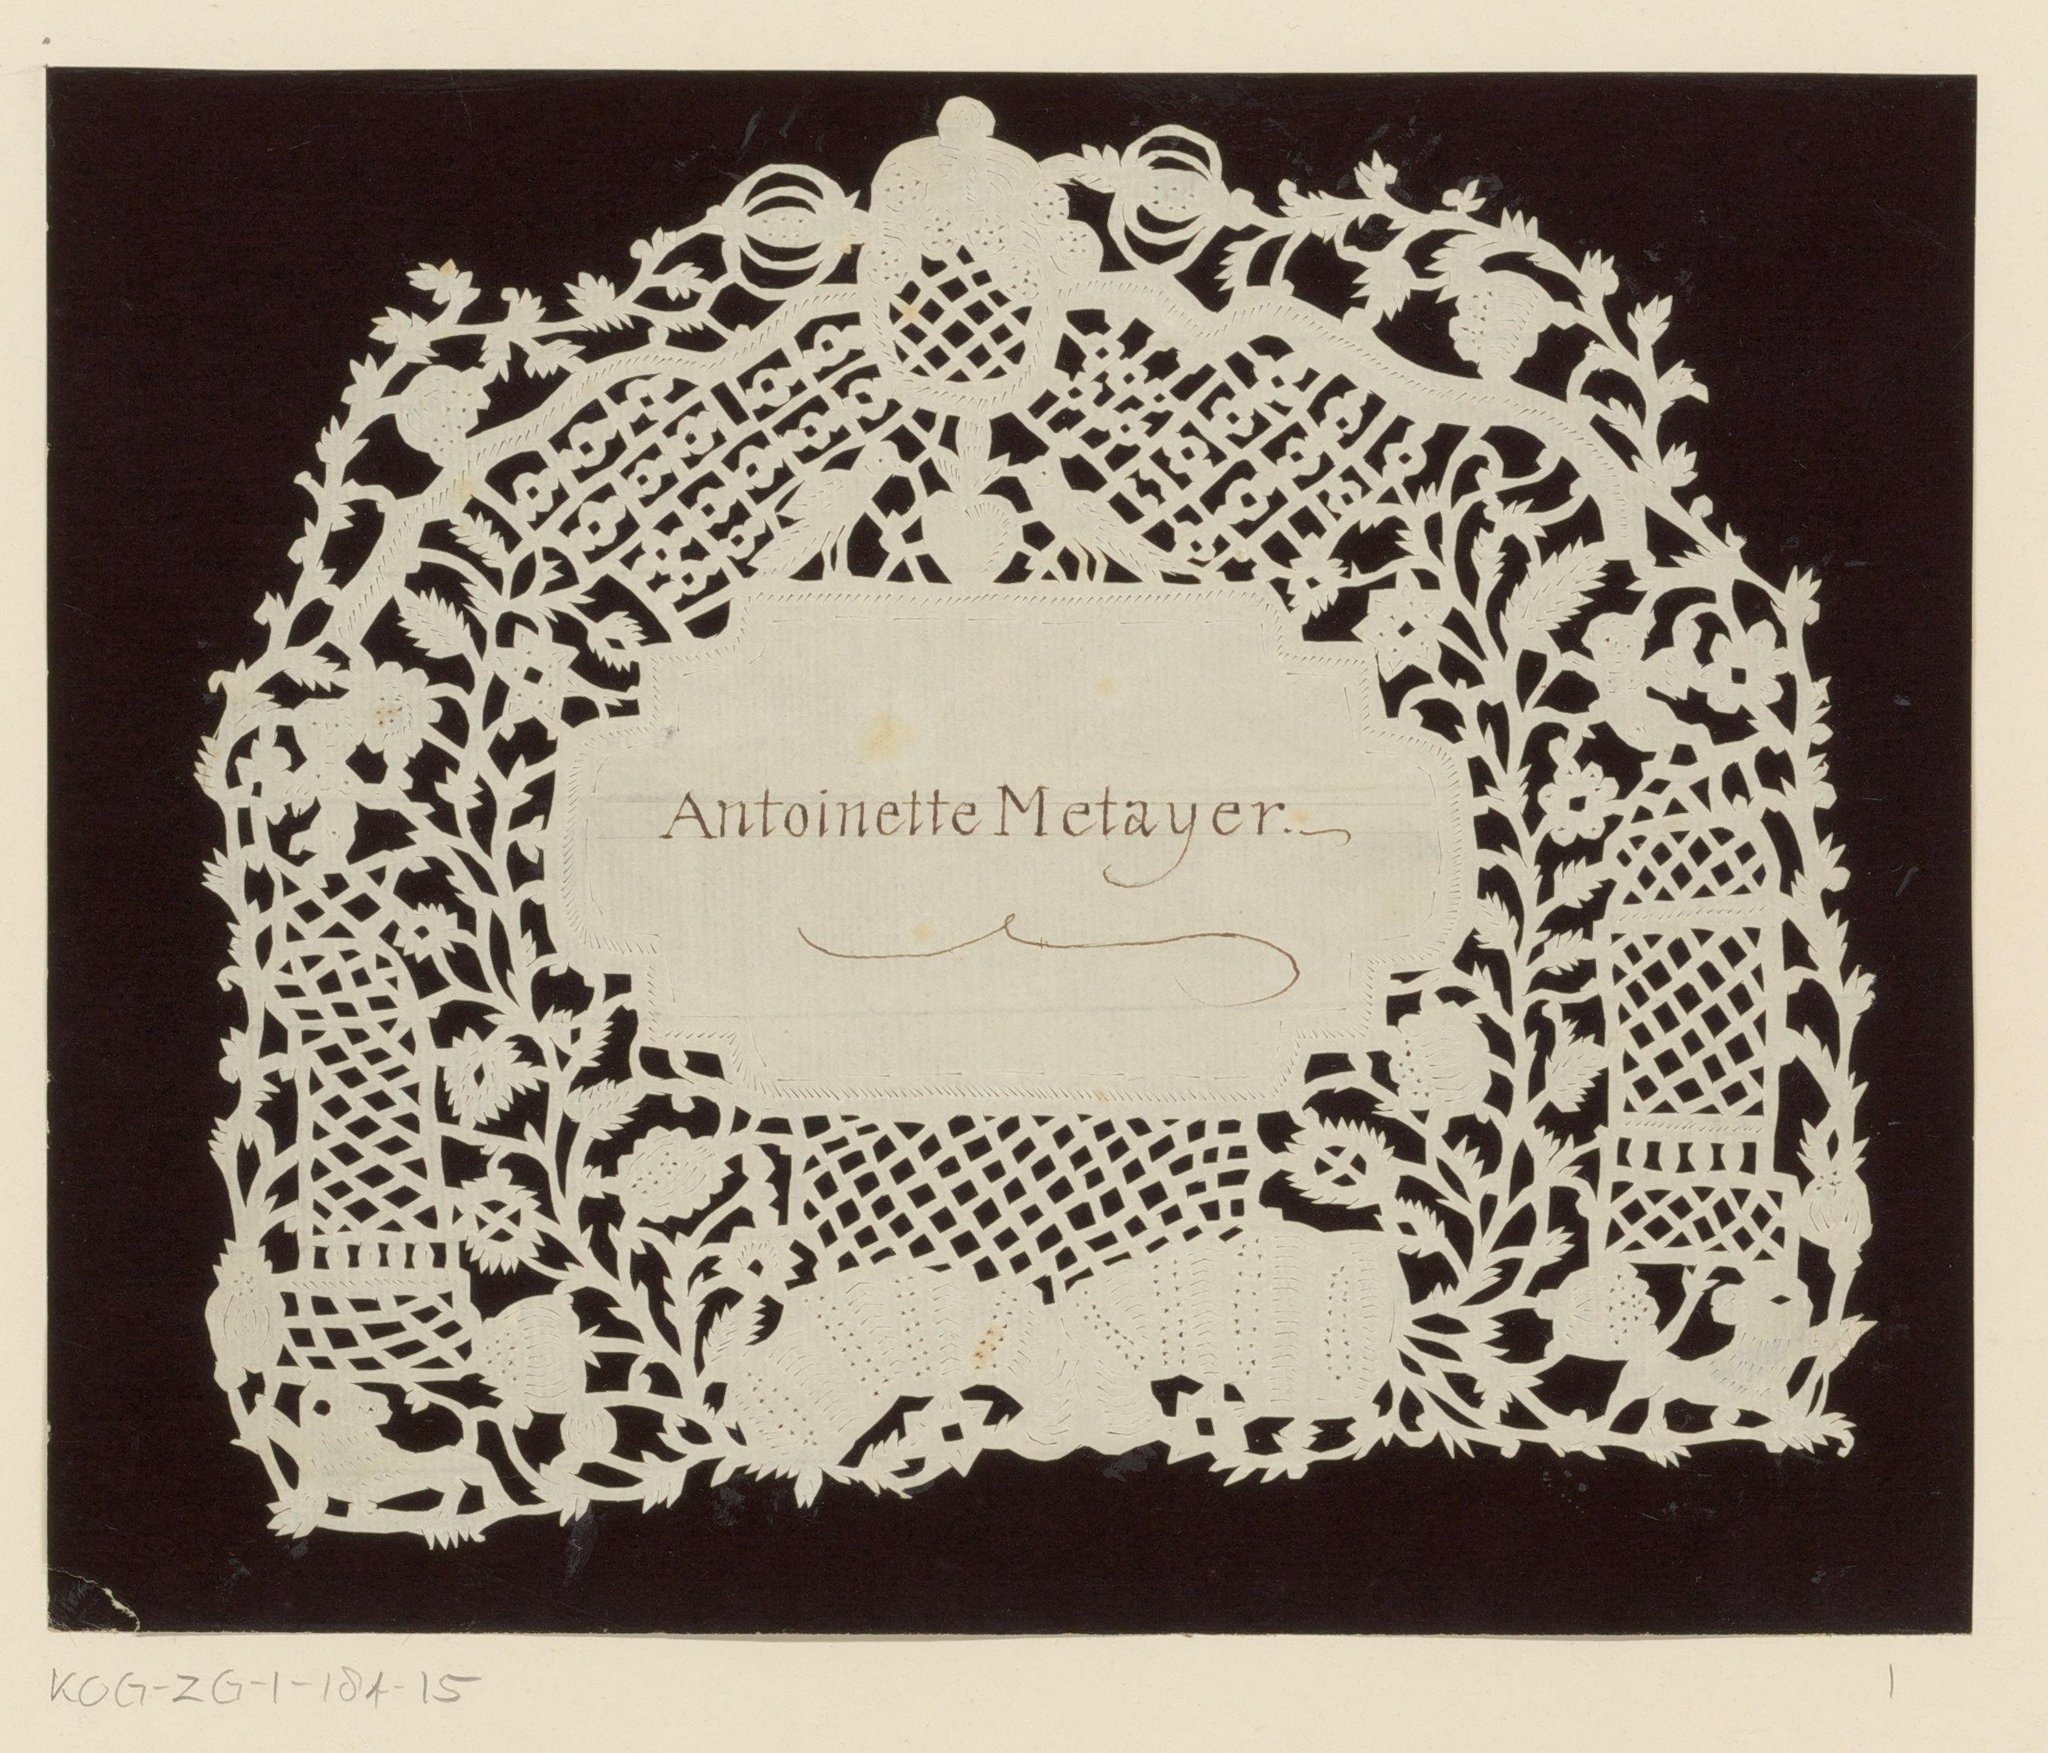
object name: cut paper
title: Huwelijksknipsel voor Antoinette Metayer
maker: Anonymous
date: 1750-1849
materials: ink, paper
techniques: cutting, pen, snipping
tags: birds, marriage, married couple, 'matrimonium', beasts of prey, predatory animals: lion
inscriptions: collector's mark: Lugt 1641, stamp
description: Plaatsaanduiding voor huwelijksmaaltijd voor Antoinette Metayer. Haar naam omlijst met twee leeuwen, bloemen en vogels. Mogelijk zijn deze knipsels gemaakt voor het huwelijk van Catharine Elisabeth Metayer en Pieter Adrian Vlacq op 7 september 1771. Onderwerpsrubrieken binnen de Atlas Zeden en Gewoonten: Schoone kunsten, Knipkunst.